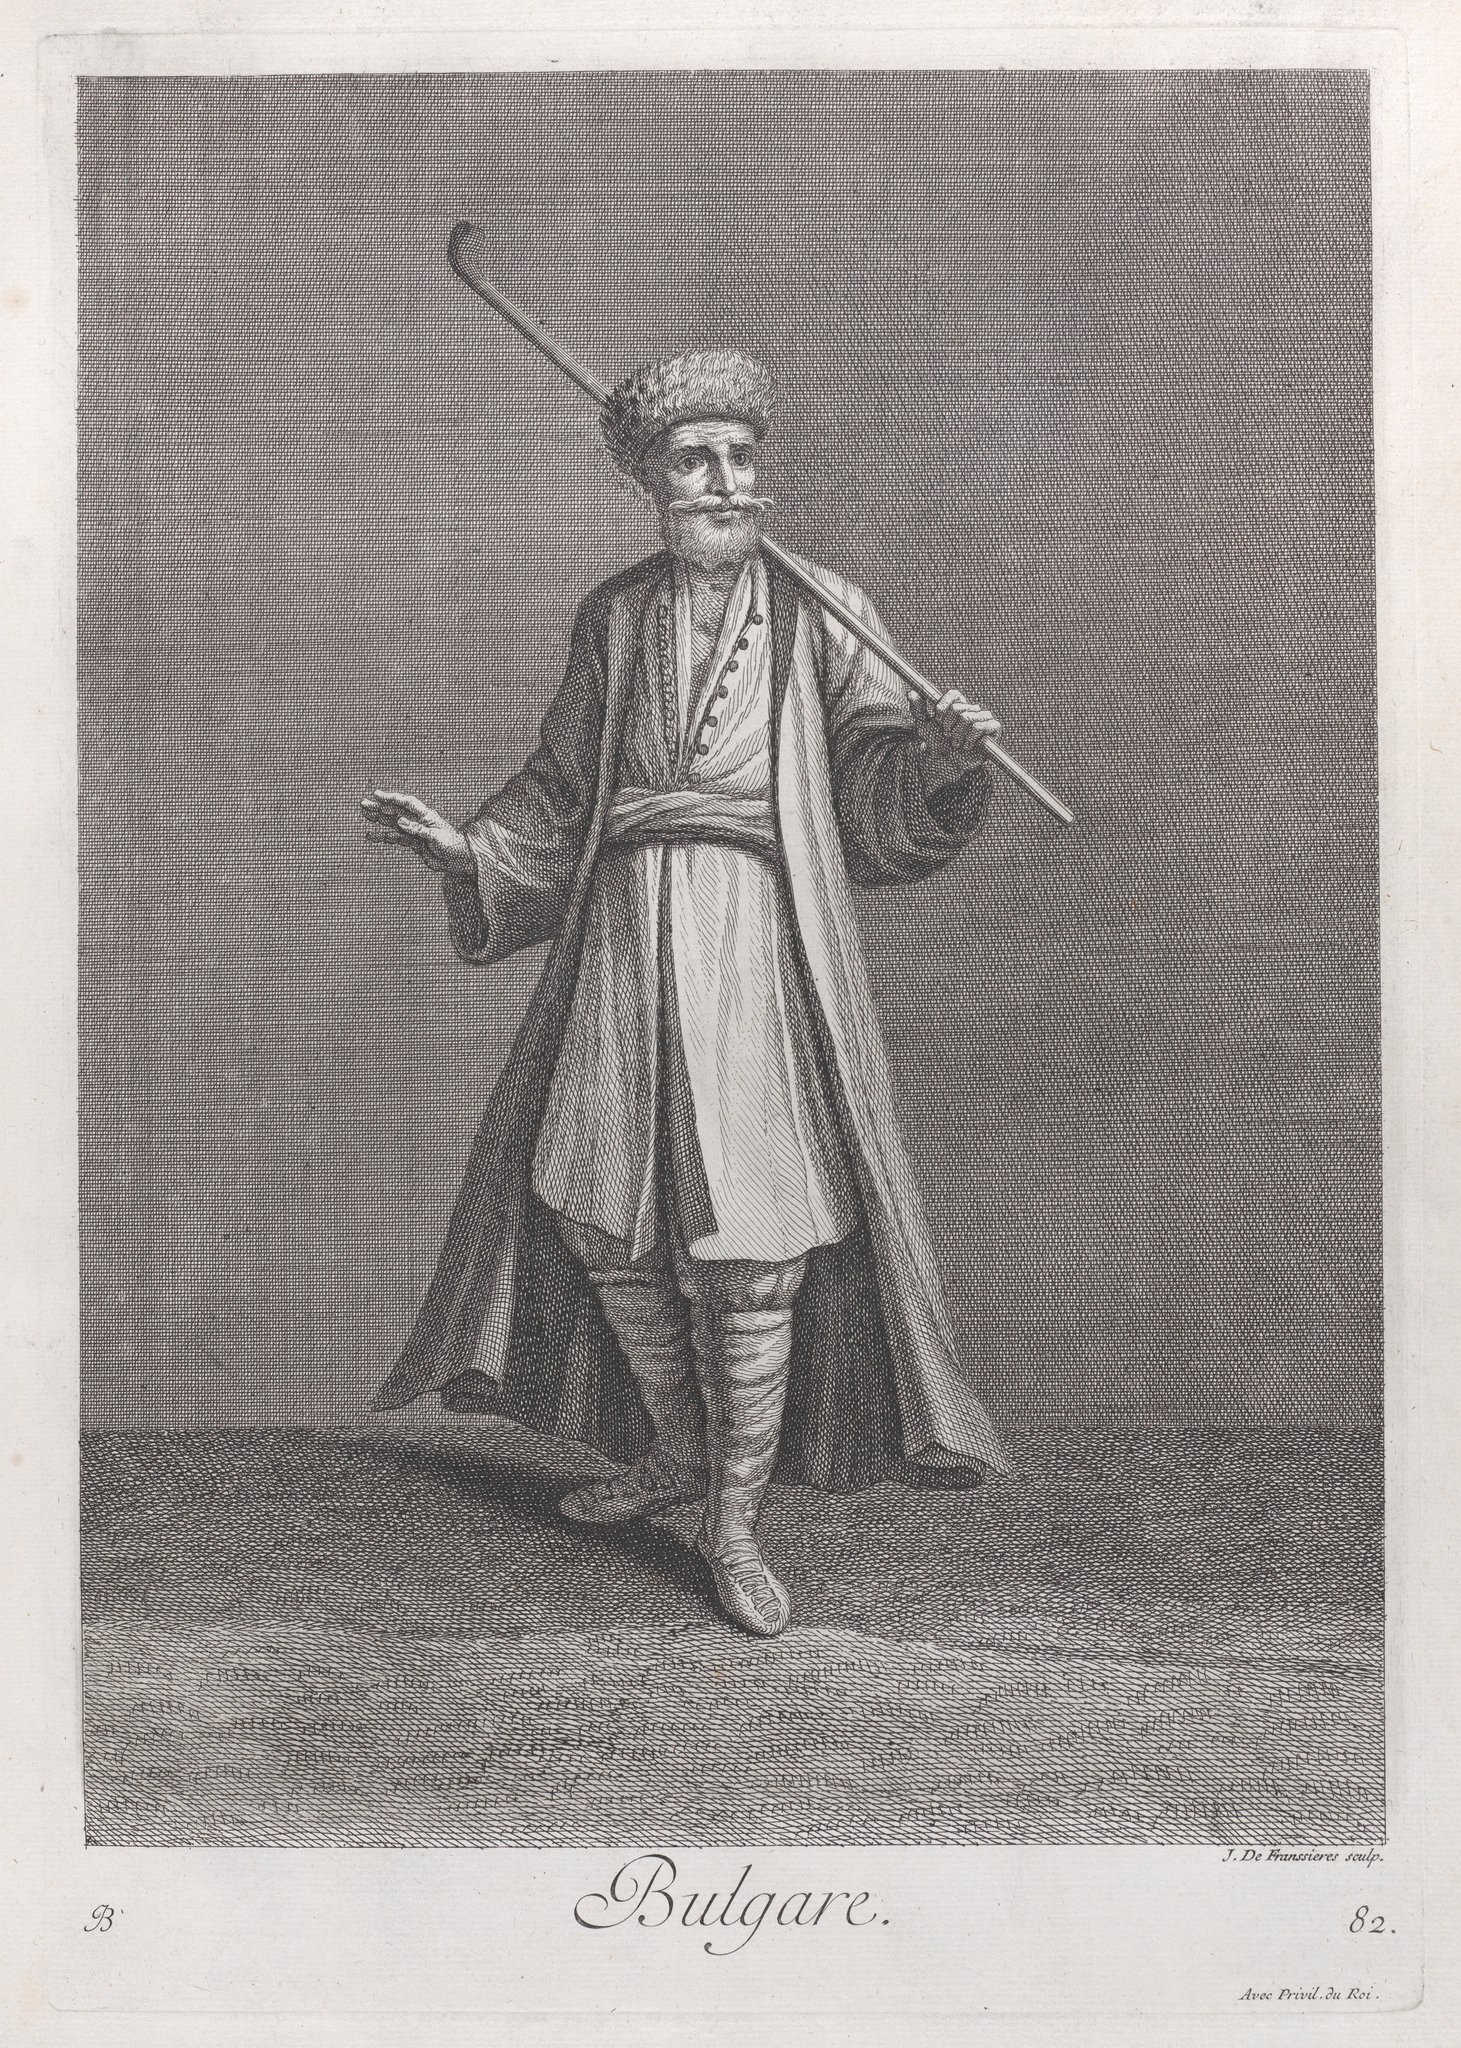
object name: print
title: Bulgare, plate 82 from "Recueil de cent estampes représentent differentes nations du Levant"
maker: jean baptiste vanmour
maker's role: artist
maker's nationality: french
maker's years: 1671-1737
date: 1714-1715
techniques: engraving, etching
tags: men